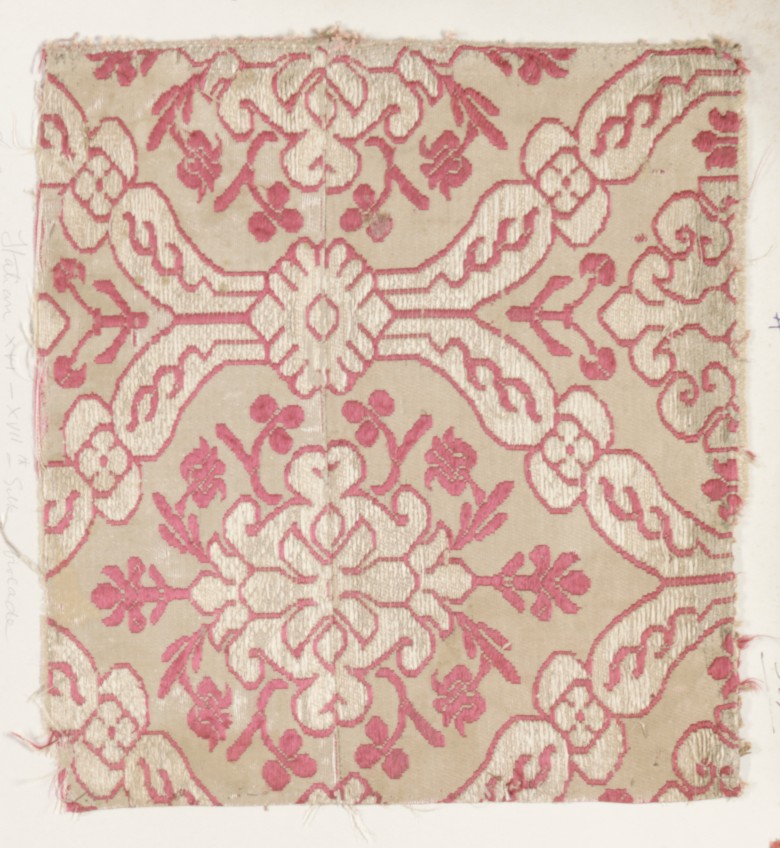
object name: fragment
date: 1501-1700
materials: metal thread, silk